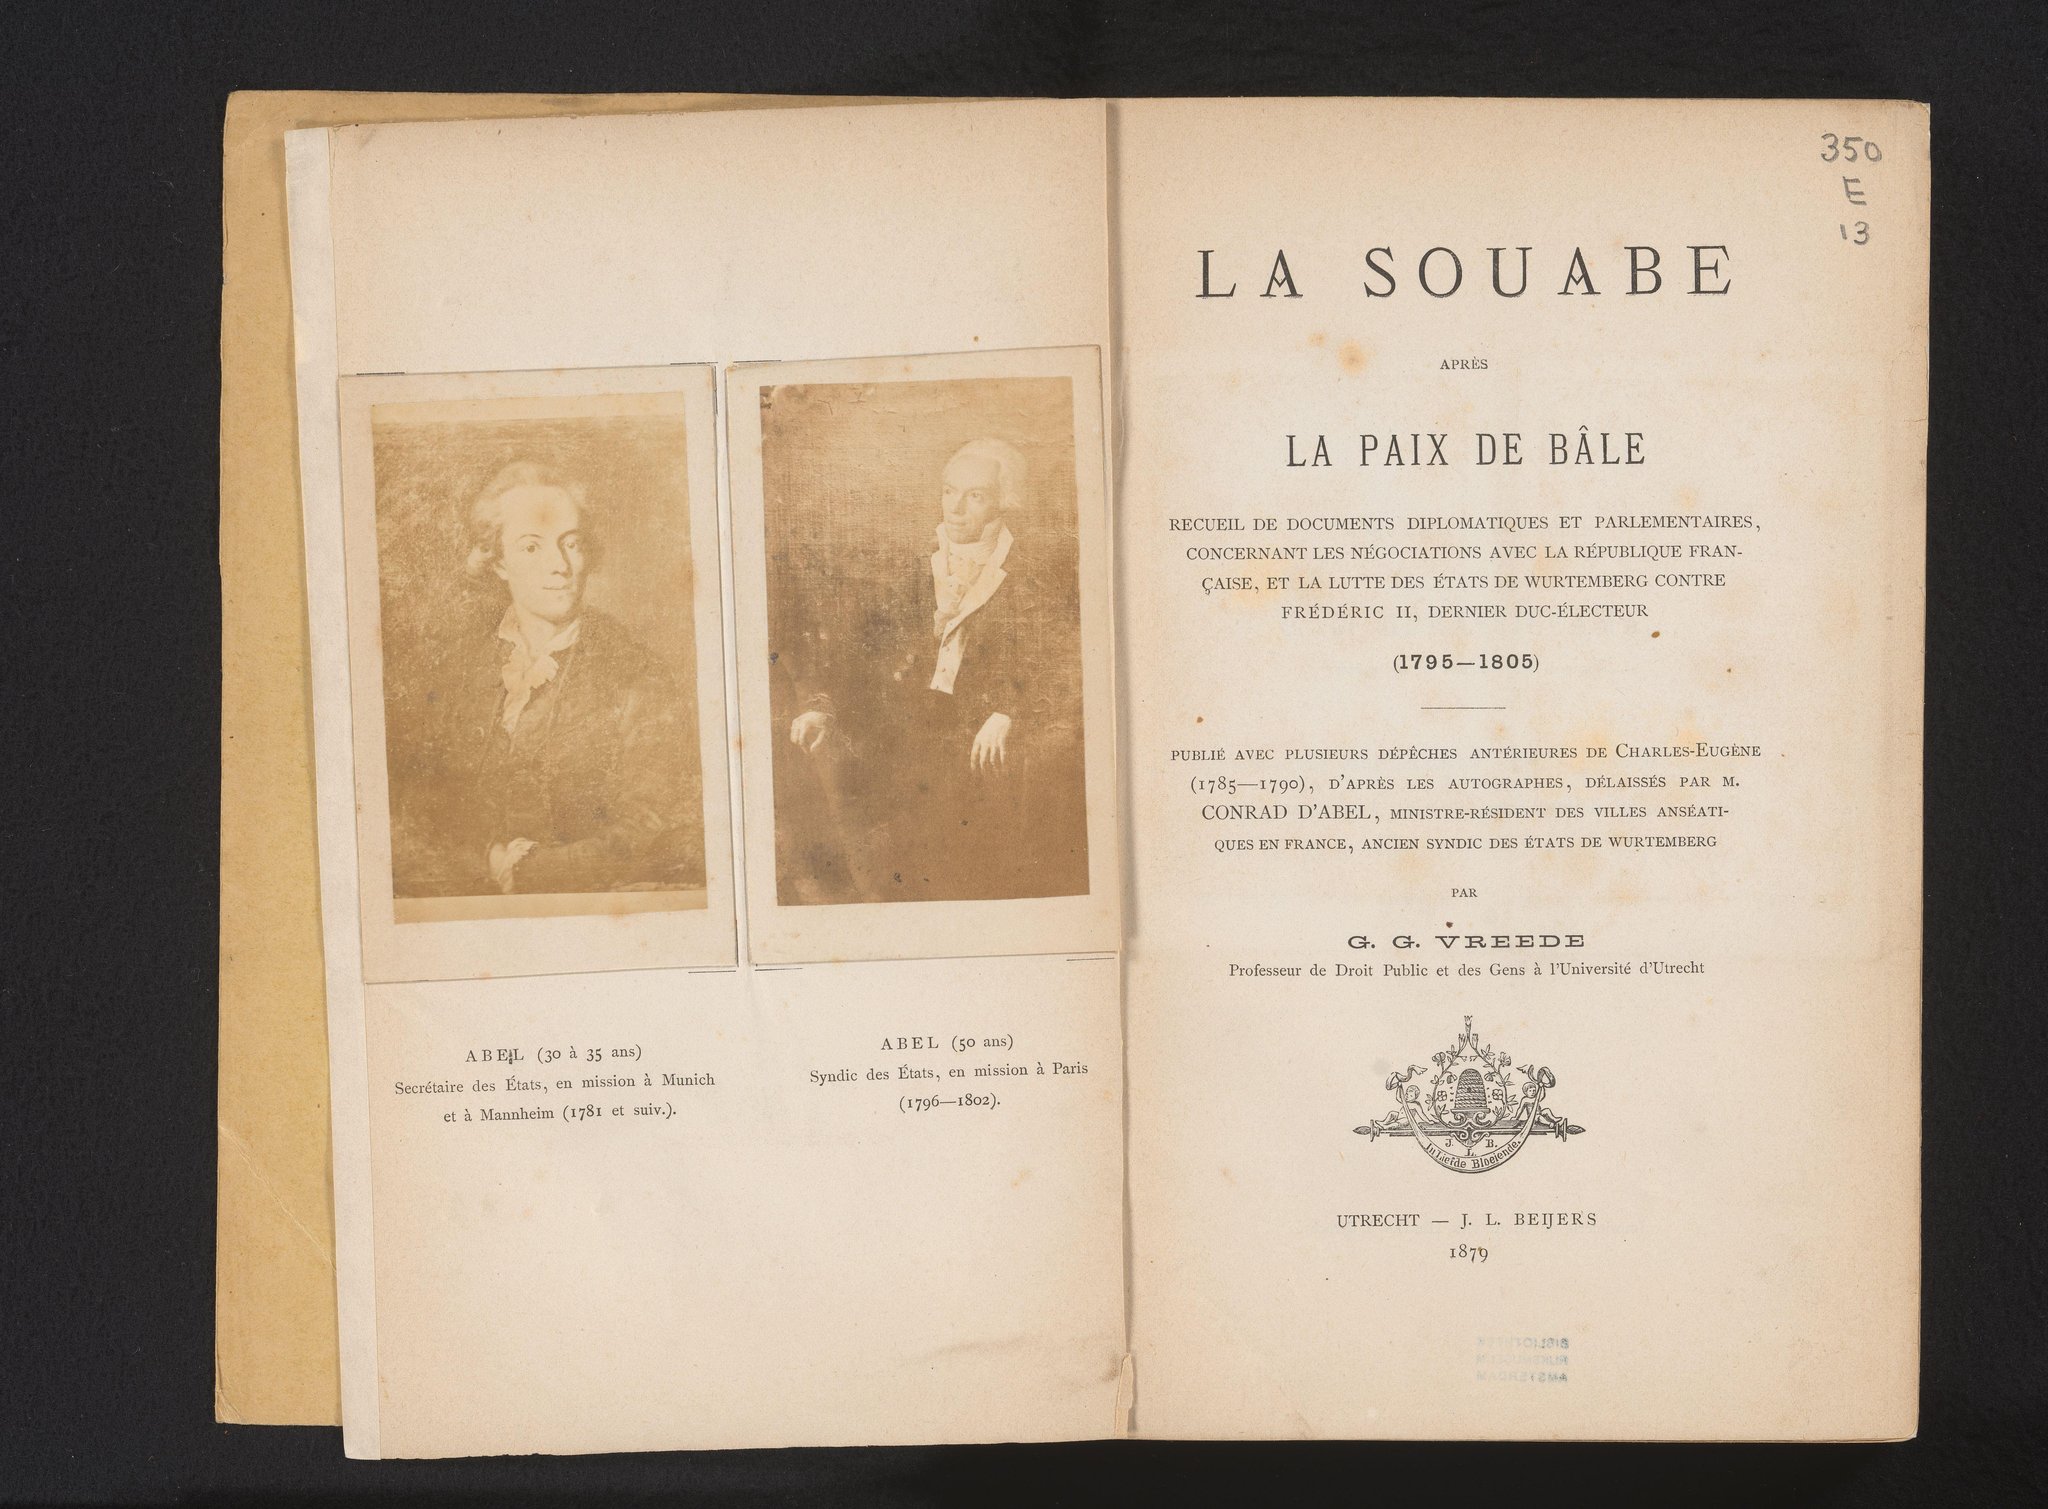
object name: carte de visite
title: Abel (50 ans) Syndic des États, en mision à Paris (1796-1802)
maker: Anonymous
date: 1869-1879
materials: paper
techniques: albumen print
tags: politician, e.g. party leader, picture, painting